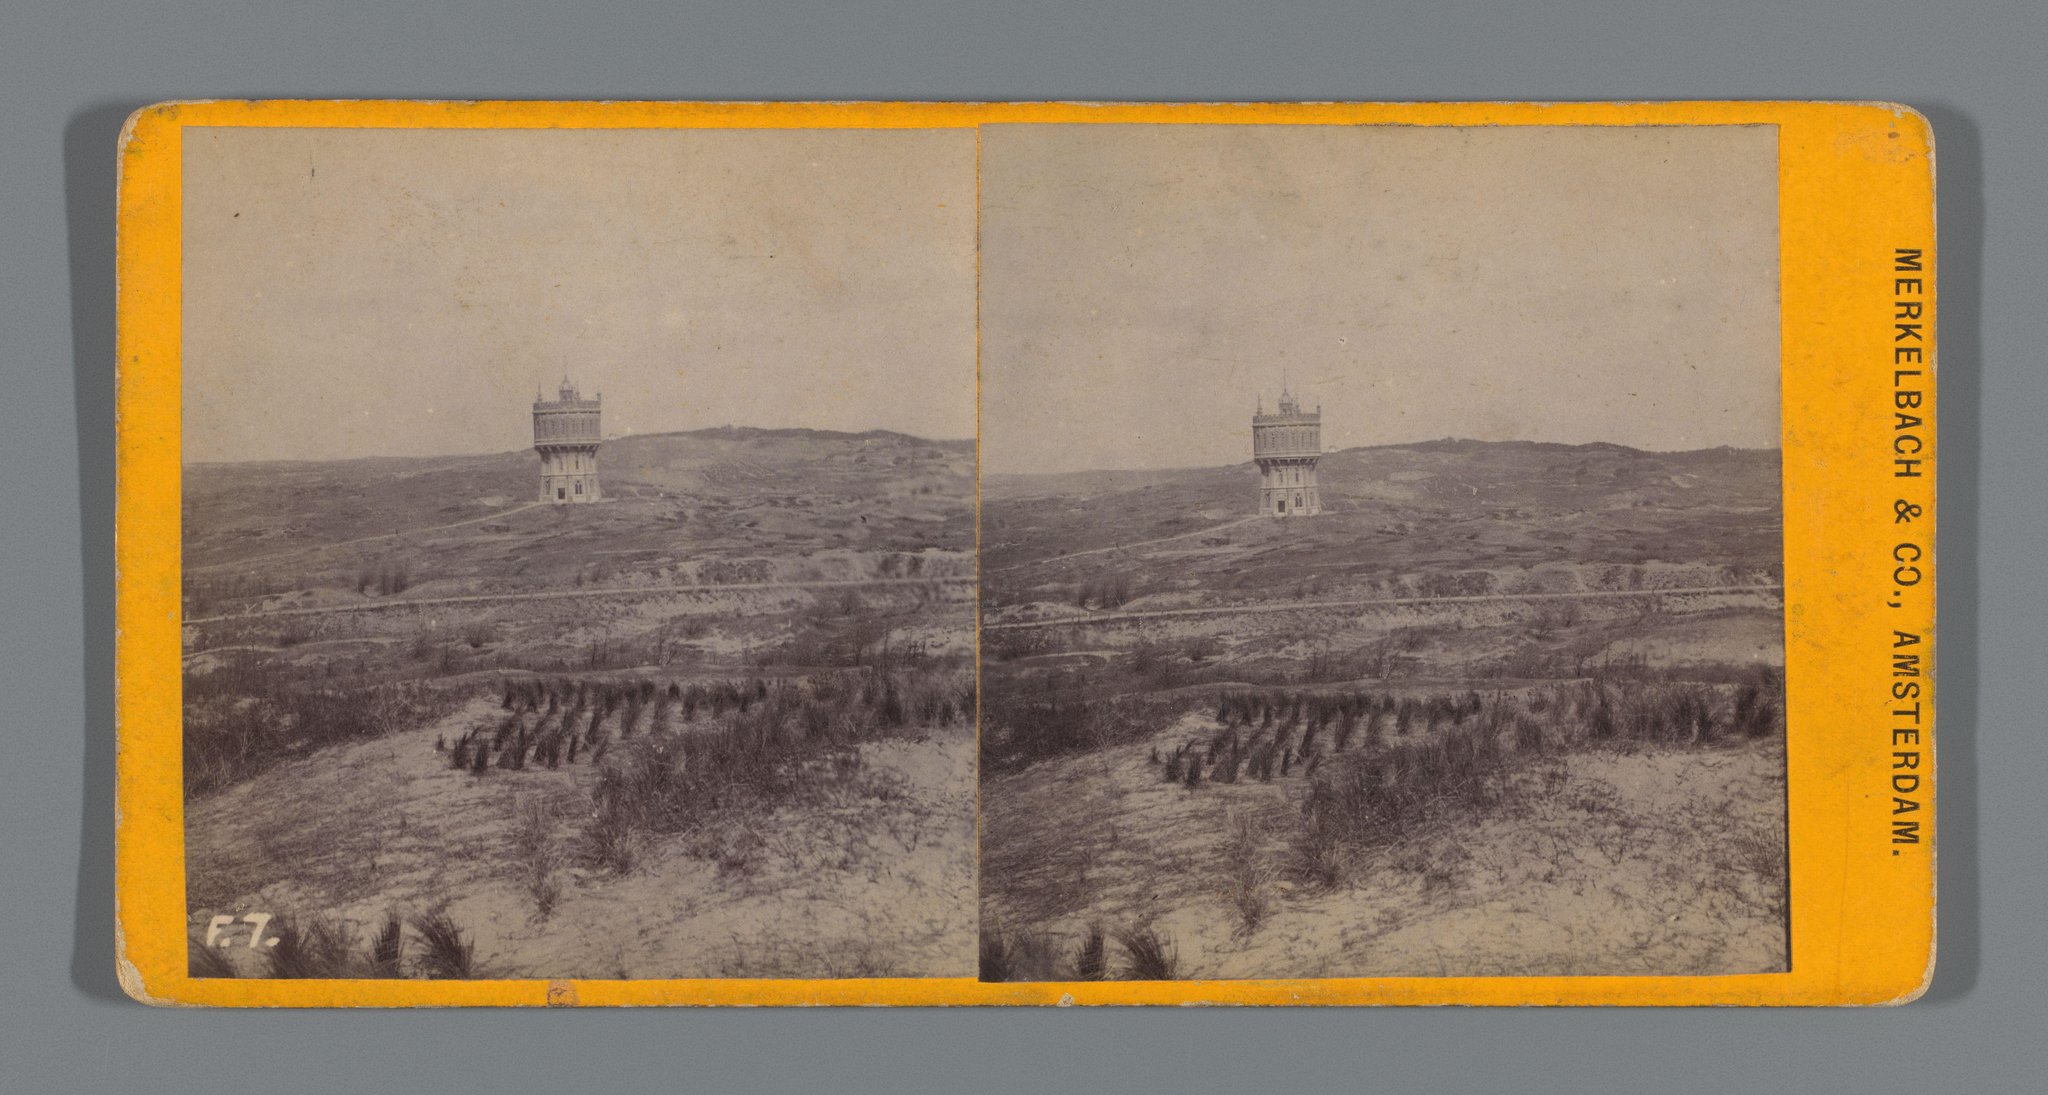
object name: stereograph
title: Aardrijkskundige Beeldengalerij, verzameld door M.J. Broekhuijsen, Hoofd eener school te Amsterdam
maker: martien johan broekhuijsen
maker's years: 1871-1956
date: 1905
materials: photographic support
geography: amsterdam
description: Onderdeel van een groep van 52 stereofoto's gebruikt in het lager onderwijs als aanvulling op schoolplaten. De gehele reeks bestond uit 274 nummers in 10 categorieën (A t/m K).